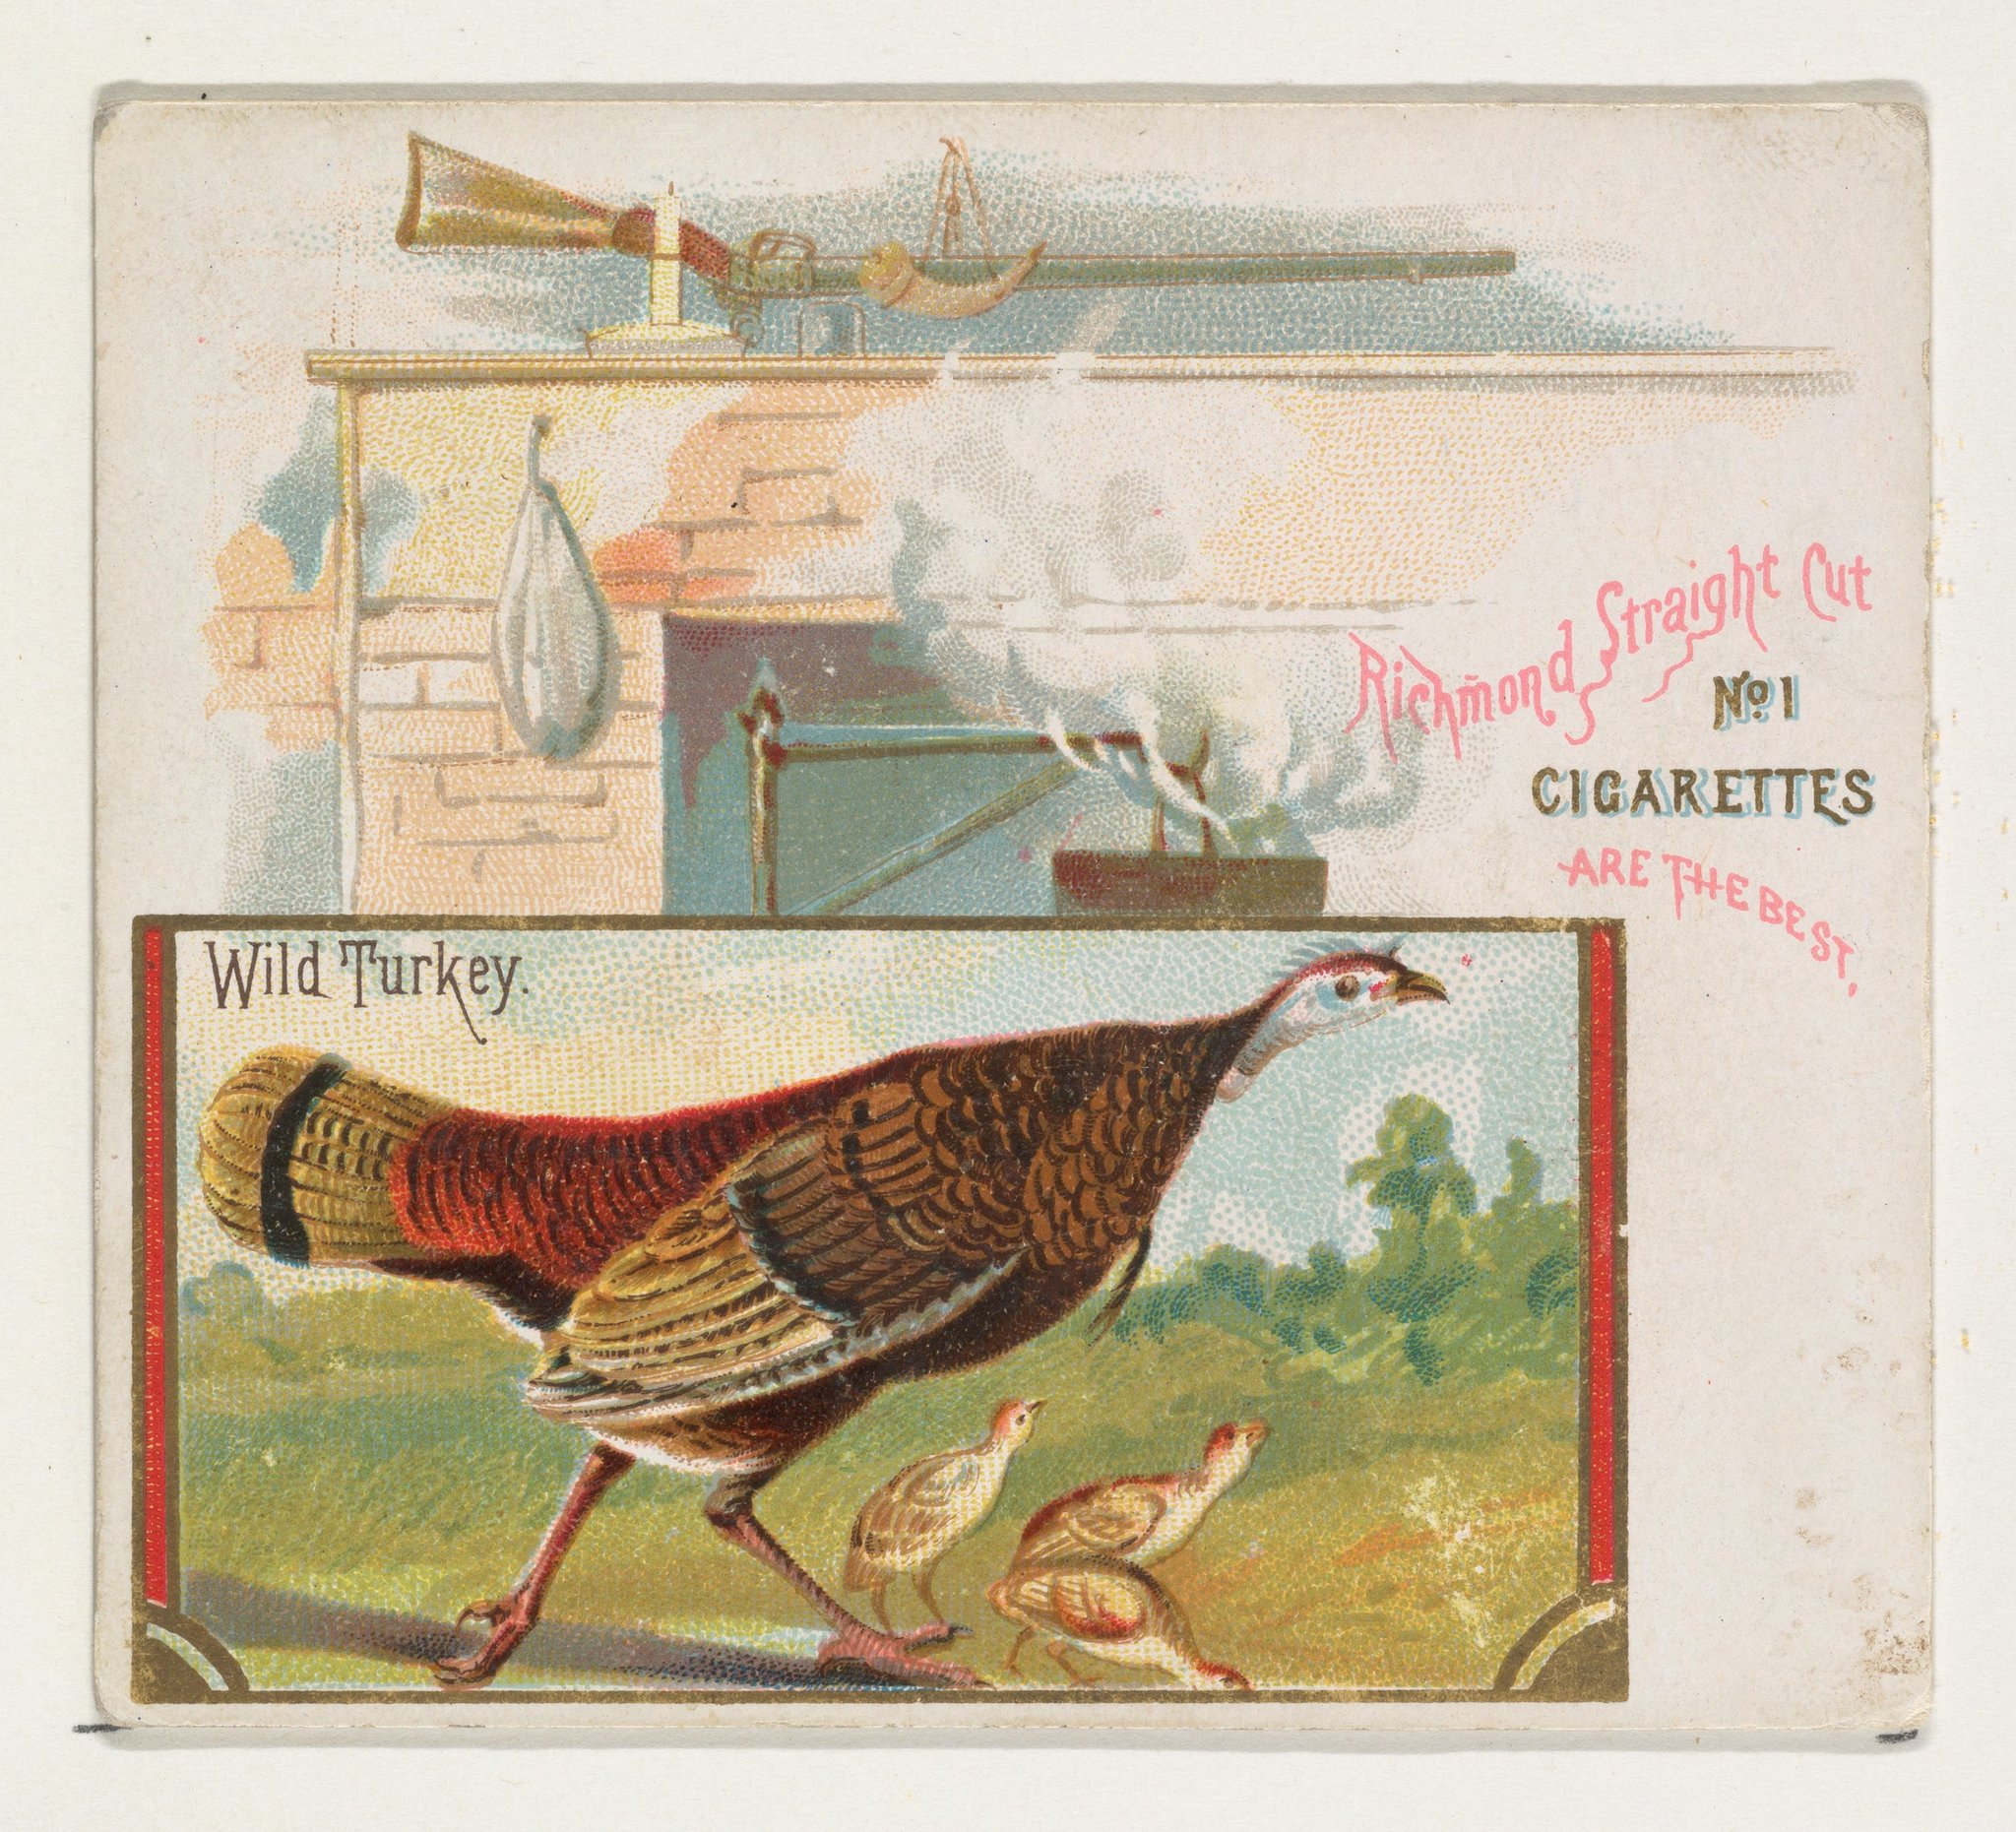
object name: print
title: Wild Turkey, from the Game Birds series (N40) for Allen & Ginter Cigarettes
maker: allen & ginter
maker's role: publisher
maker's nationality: american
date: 1888-1890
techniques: color lithograph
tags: firearms,turkeys